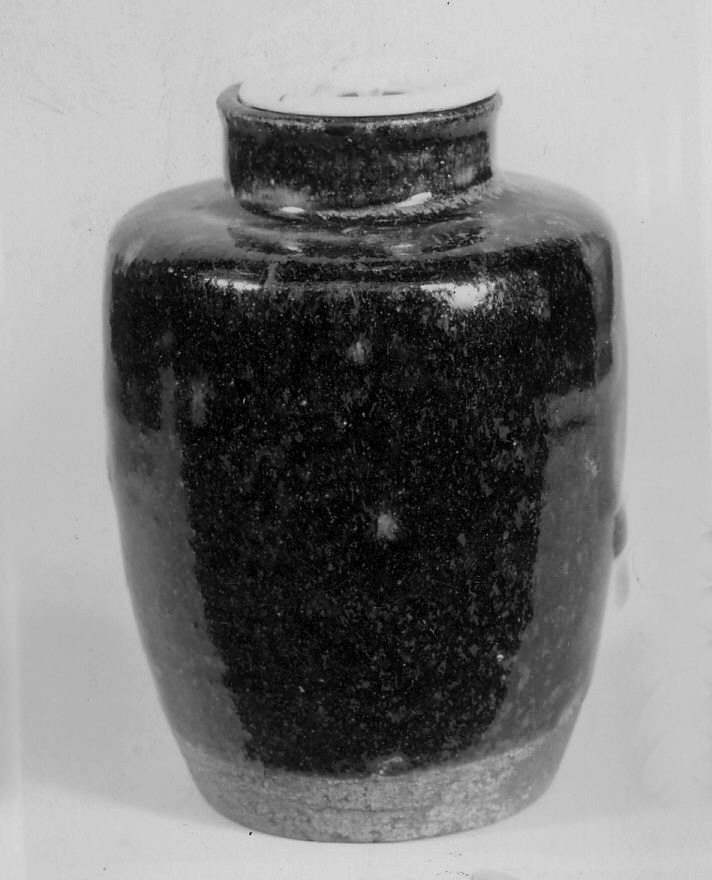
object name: tea jar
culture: japanese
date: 1701-1800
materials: clay, glaze